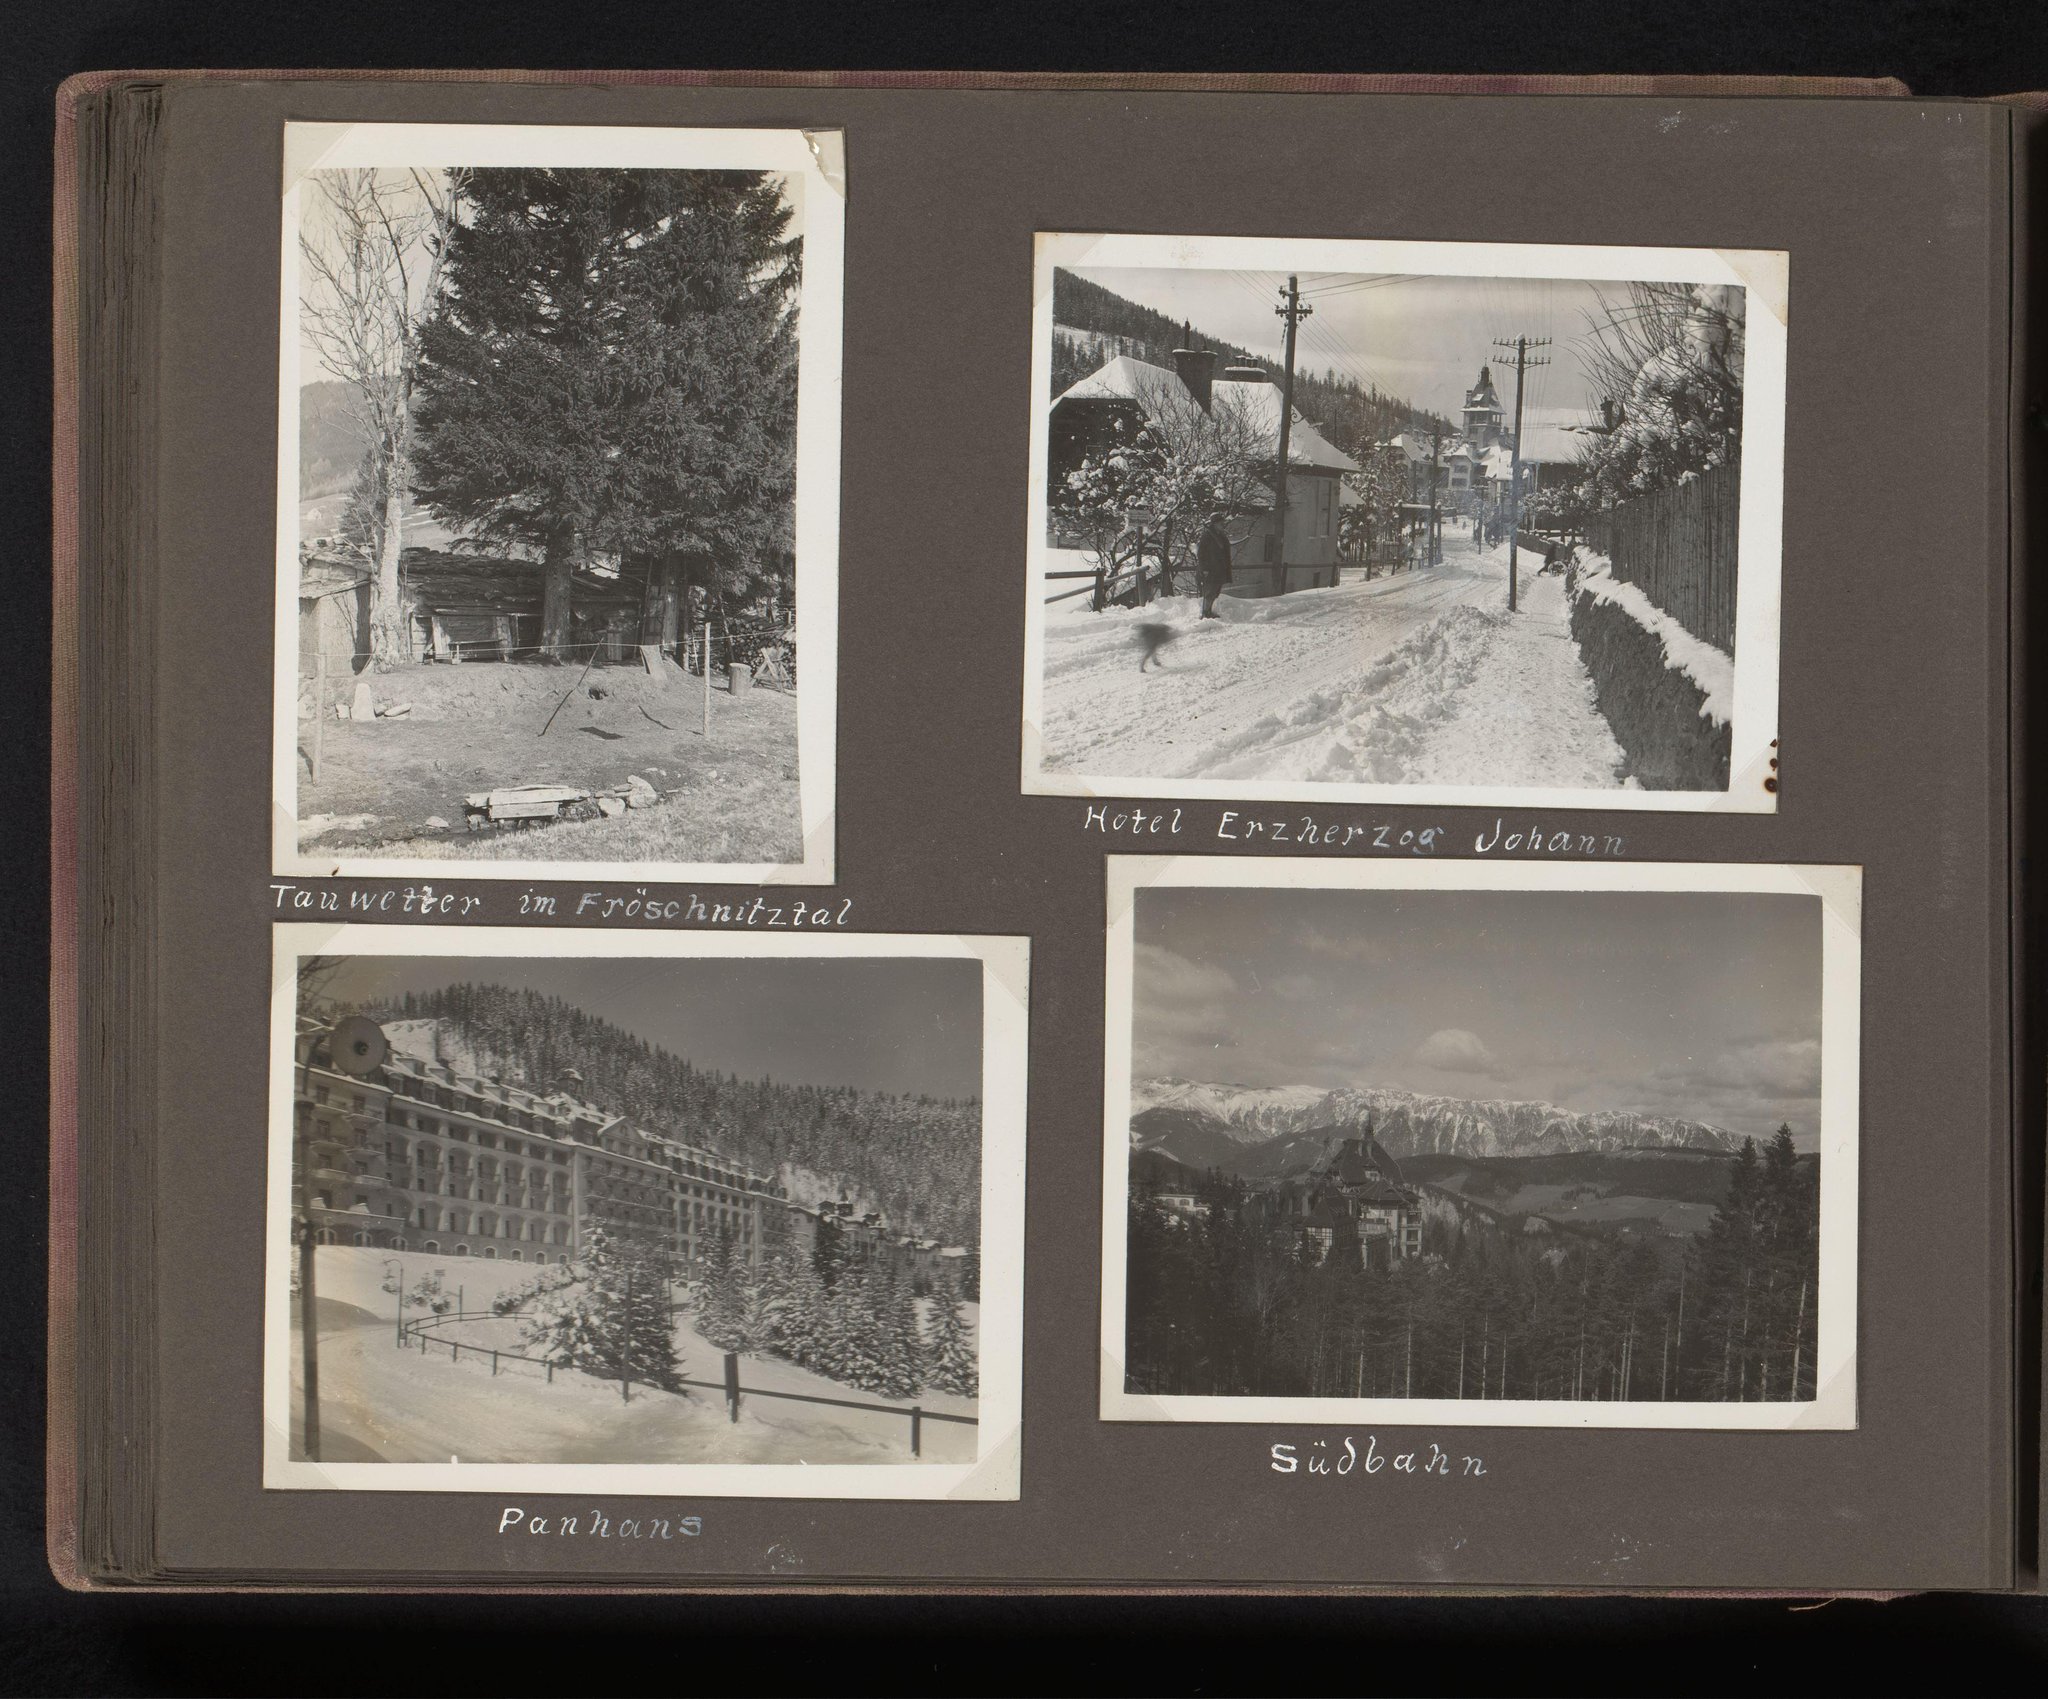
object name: photograph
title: Wintersportvakantie in Semmering, Oostenrijk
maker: berti hoppe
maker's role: fotograaf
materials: cardboard, photographic support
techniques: gelatin silver print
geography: semmering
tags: thaw, hotel, hostelry, inn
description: Drie gezichten op gebouwen en een foto van een landschap tijdens een dooiperiode in Semmering. In de onderschriften is vermeld dat het gaat om Hotel Erzherzog Johann, Hotel Panhans en het Südbahnhotel. Deze foto's maken deel uit van een album.